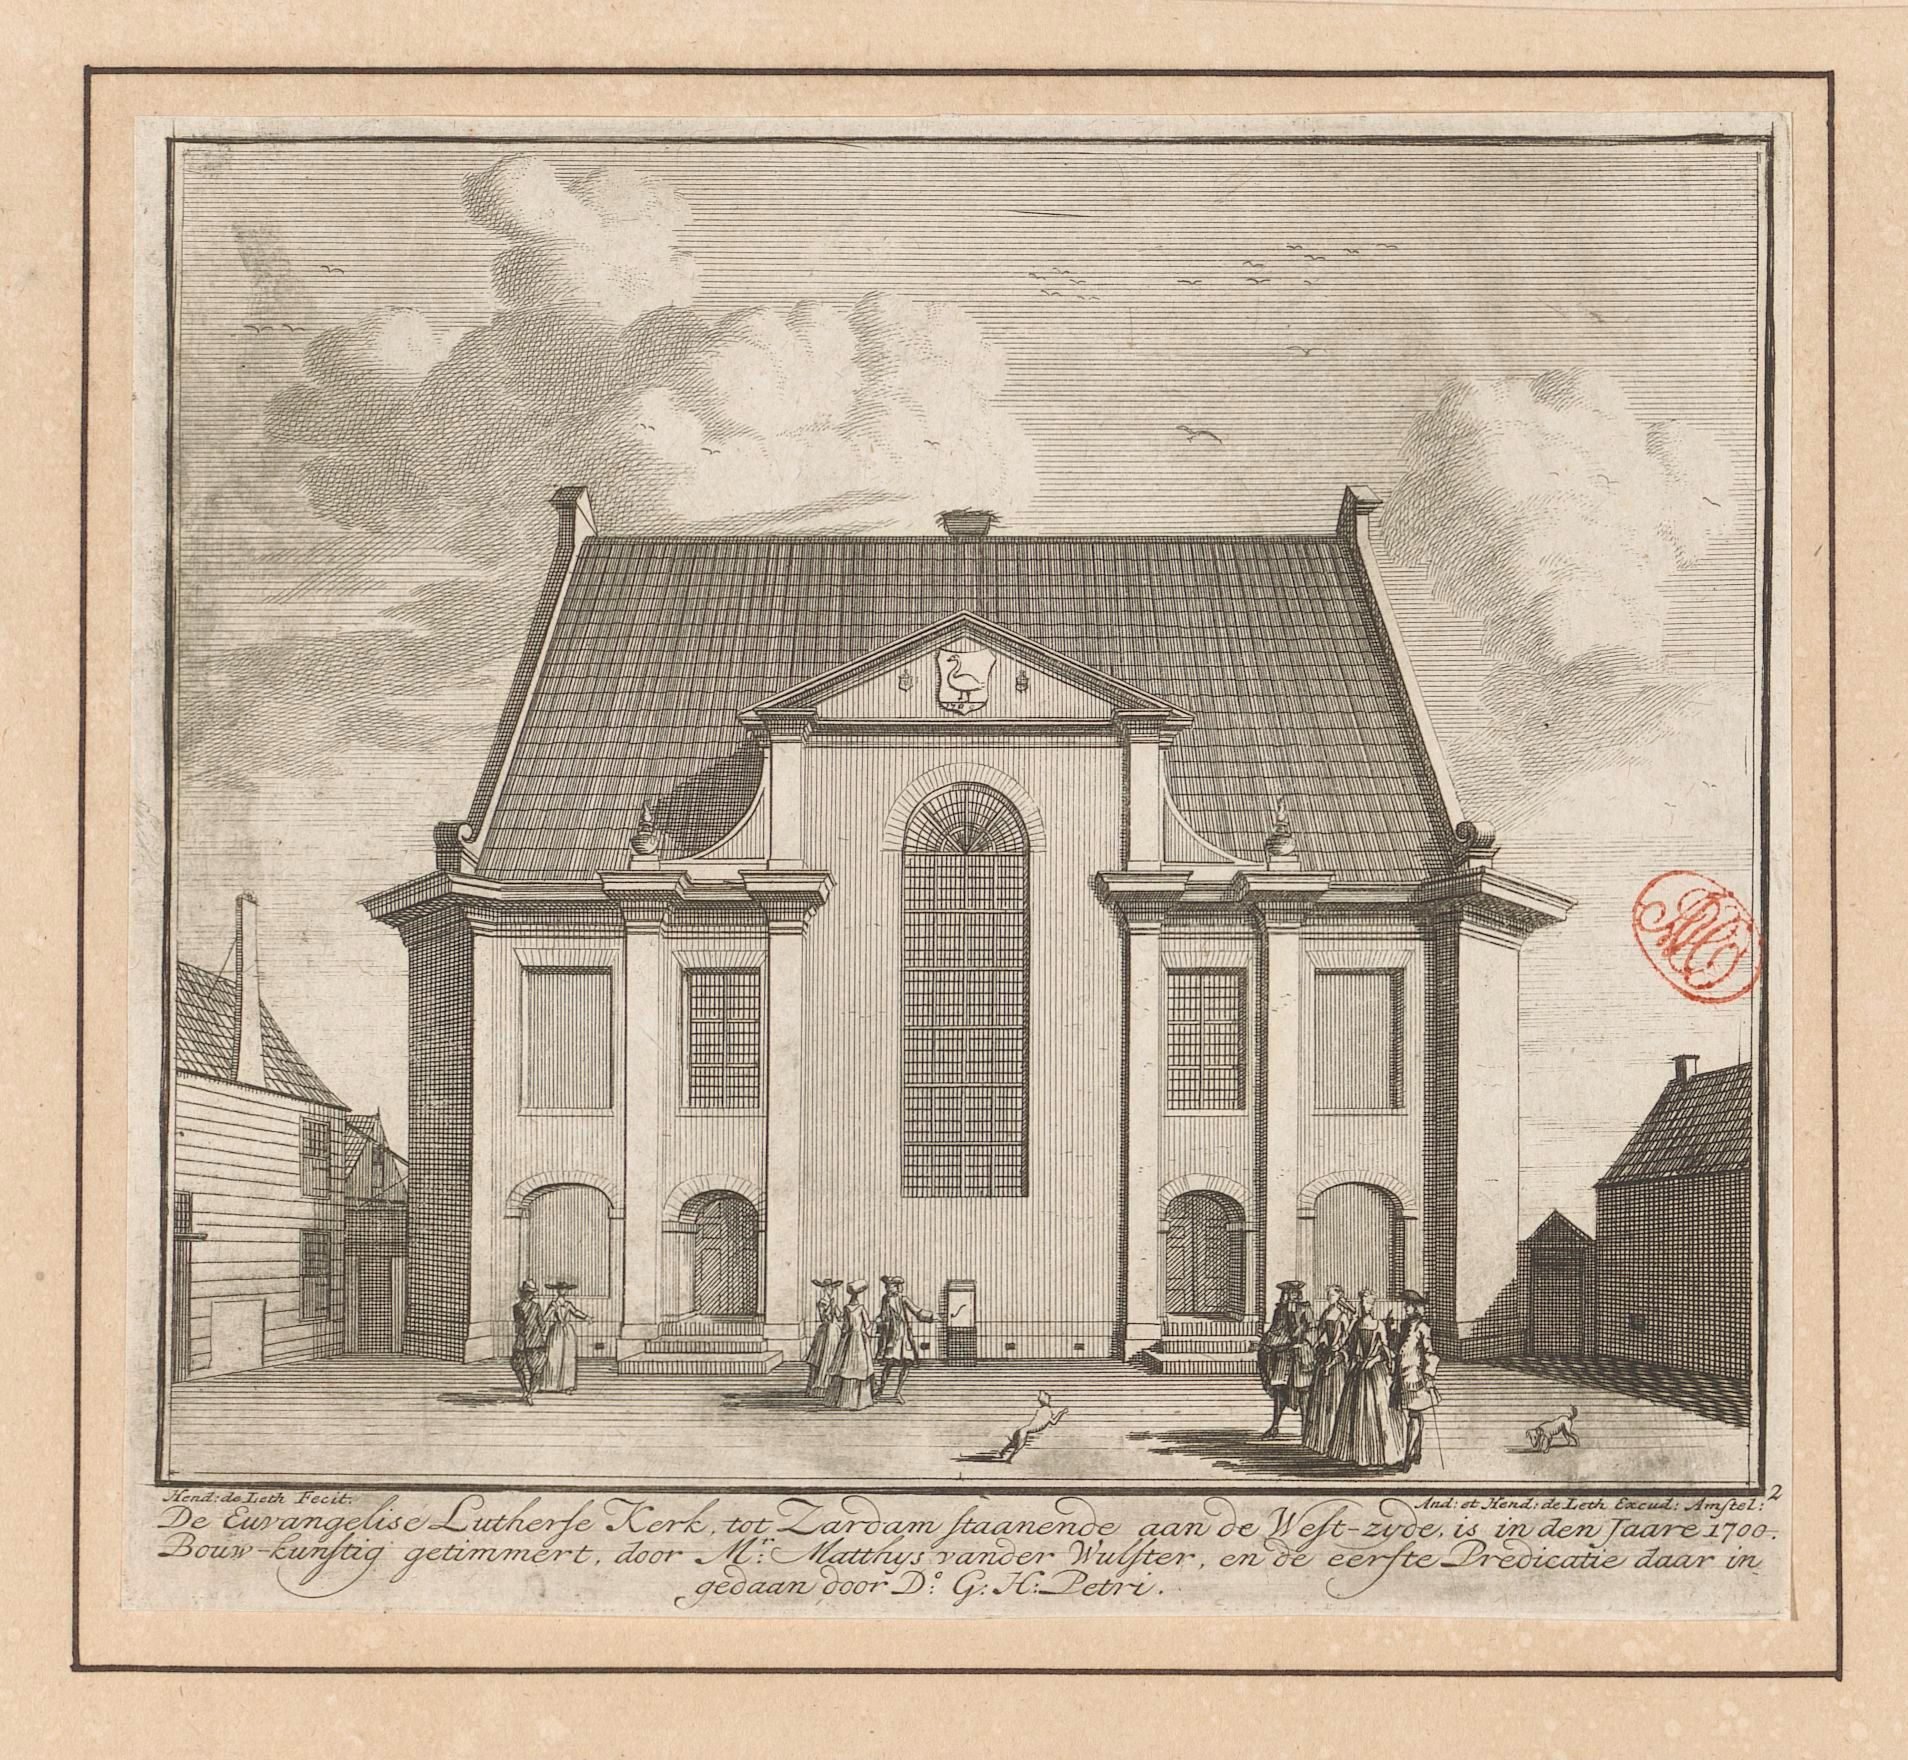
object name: print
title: De Lutherse Kerk te Zaandam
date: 1700-1721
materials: paper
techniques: engraving, etching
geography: amsterdam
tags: protestant churches and denominations (lutherans), church (exterior)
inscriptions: collector's mark: Lugt 195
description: Gezicht op de Lutherse Kerk te Zaandam, gebouwd in 1699. Onder de afbeelding een gedicht van twee verzen van twee regels in het Nederlands.